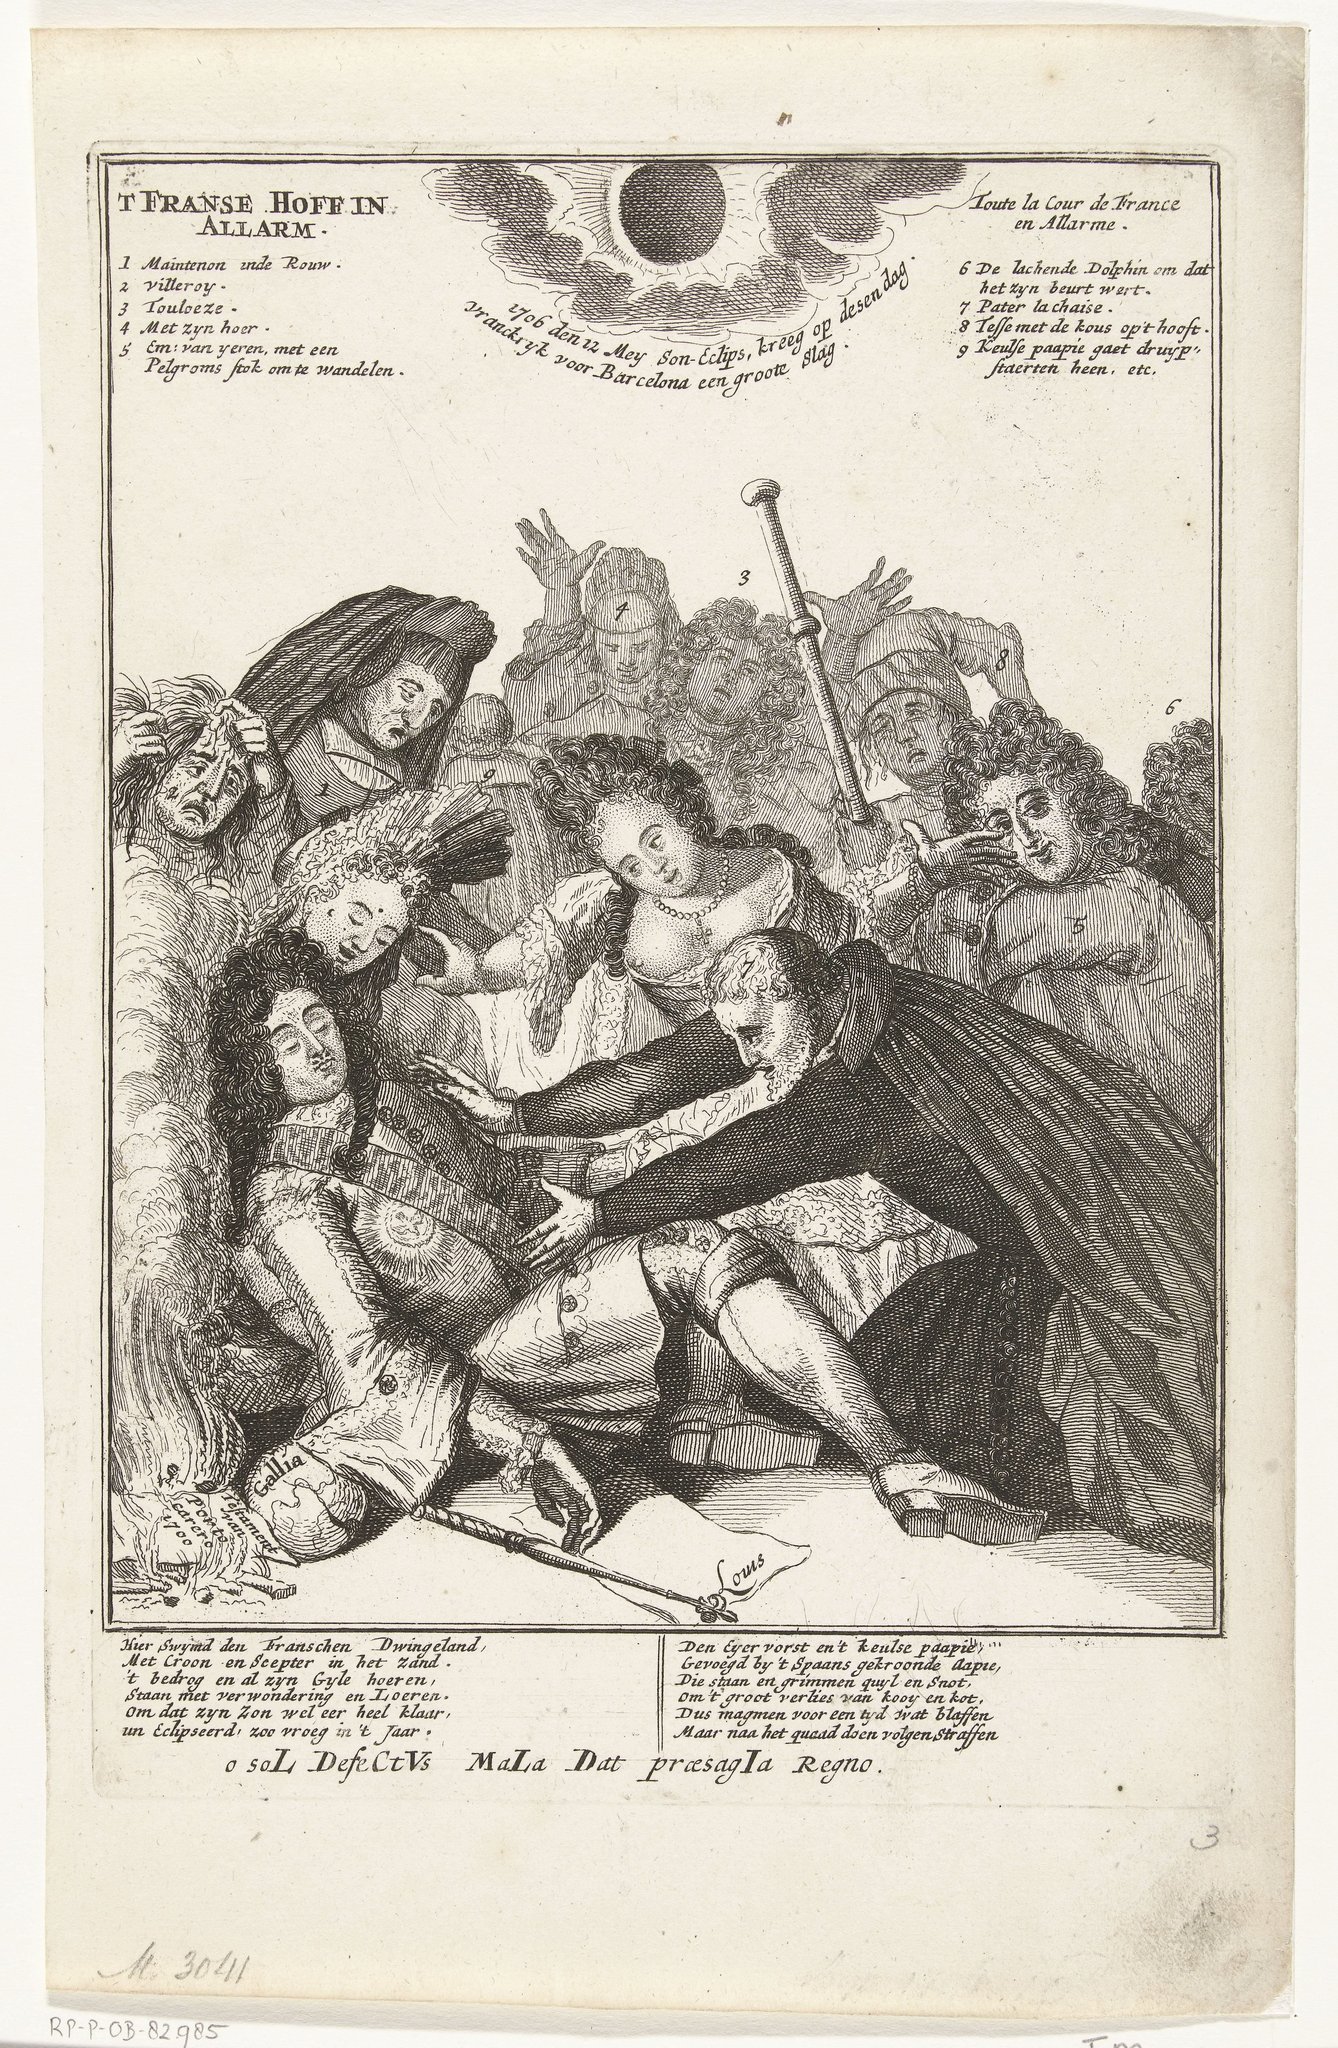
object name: cartoon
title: Lodewijk XIV flauwgevallen na het nieuws over het verlies van Barcelona, 1706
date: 1706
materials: paper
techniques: etching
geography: northern netherlands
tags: lodewijk xiv (koning van frankrijk), paris, clergyman, madame de maintenon, solar eclipse, political caricatures and satires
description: Lodewijk XIV flauwgevallen na het nieuws over het verlies van Barcelona. Madame de Maintenon en père La Chaise proberen hem te wekken. Bovenaan de zonsverduistering op 12 mei 1706 tijdens het verlies van Barcelona. Met verzen in het Nederlands. Onderdeel van een reeks van 19 spotprenten op de Fransen en bondgenoten uit het jaar 1706.